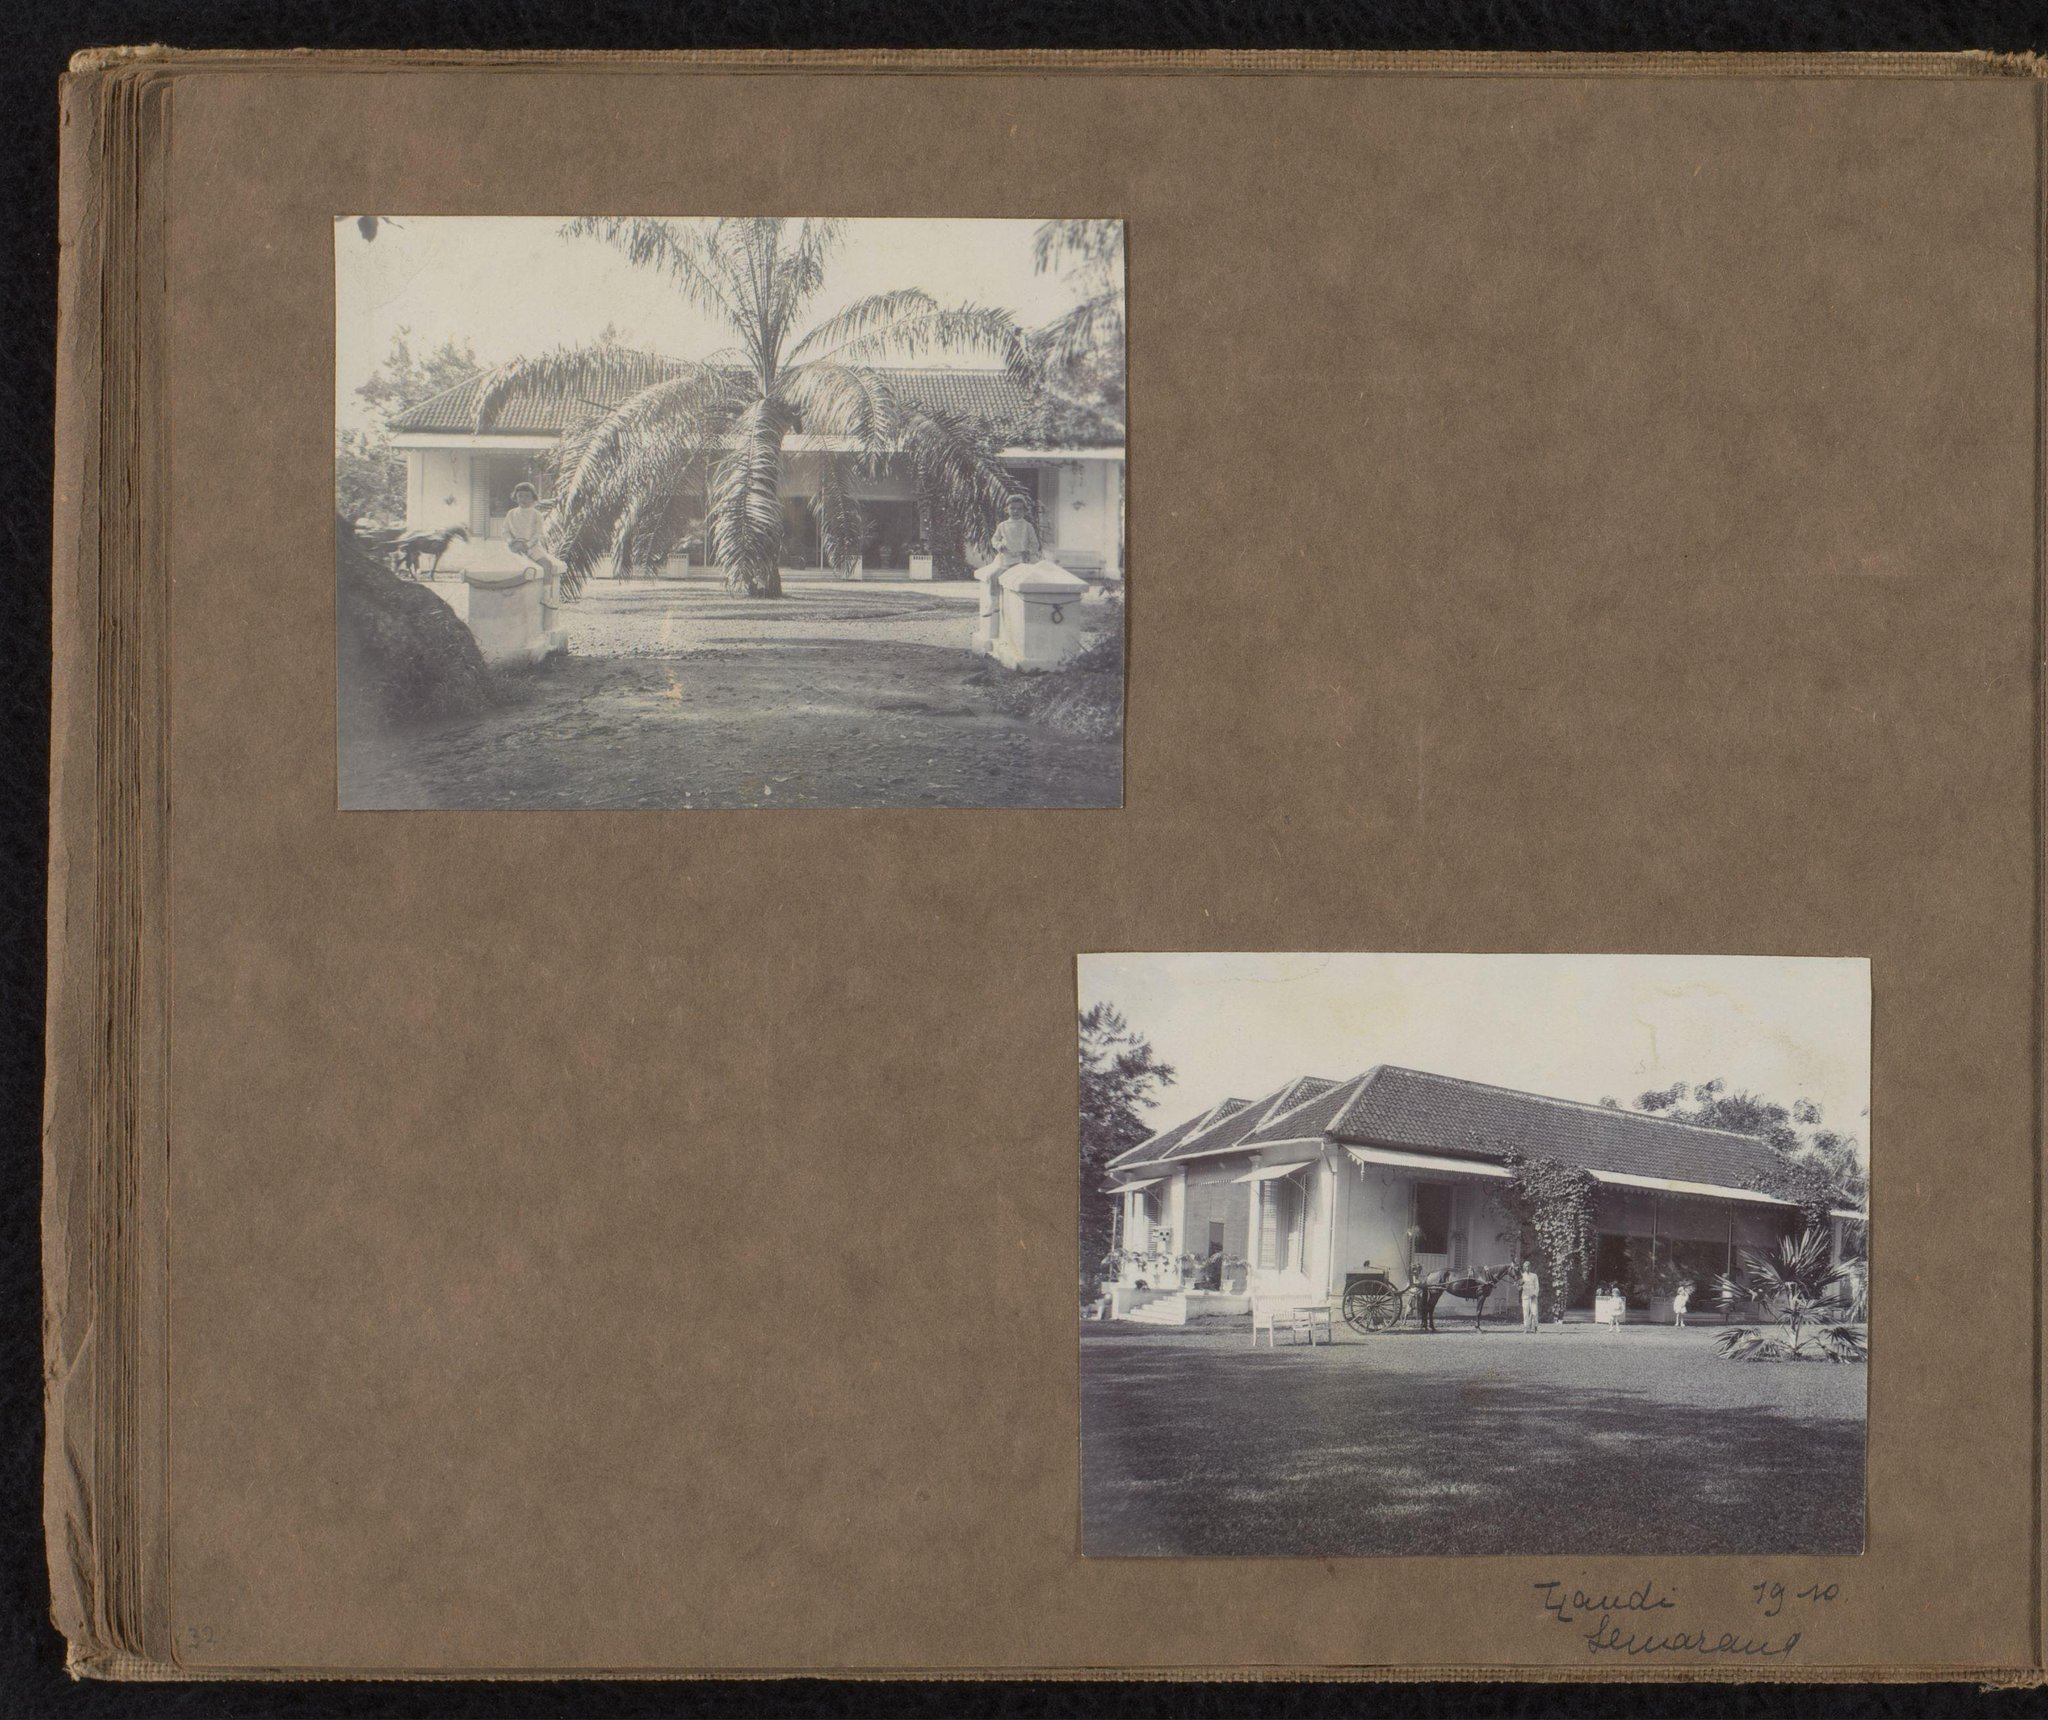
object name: photograph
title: Twee foto's van een huis in Semarang met twee kinderen en een bediende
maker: carolina frederika onnen (lien/loen)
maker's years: 1896-1983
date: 1910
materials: paper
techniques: collodion silver print, matte daylight collodion silver print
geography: semarang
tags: garden, villa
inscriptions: inscription: ‘Tjandi 1910/ Semarang’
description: Deze foto's maken deel uit van een album.